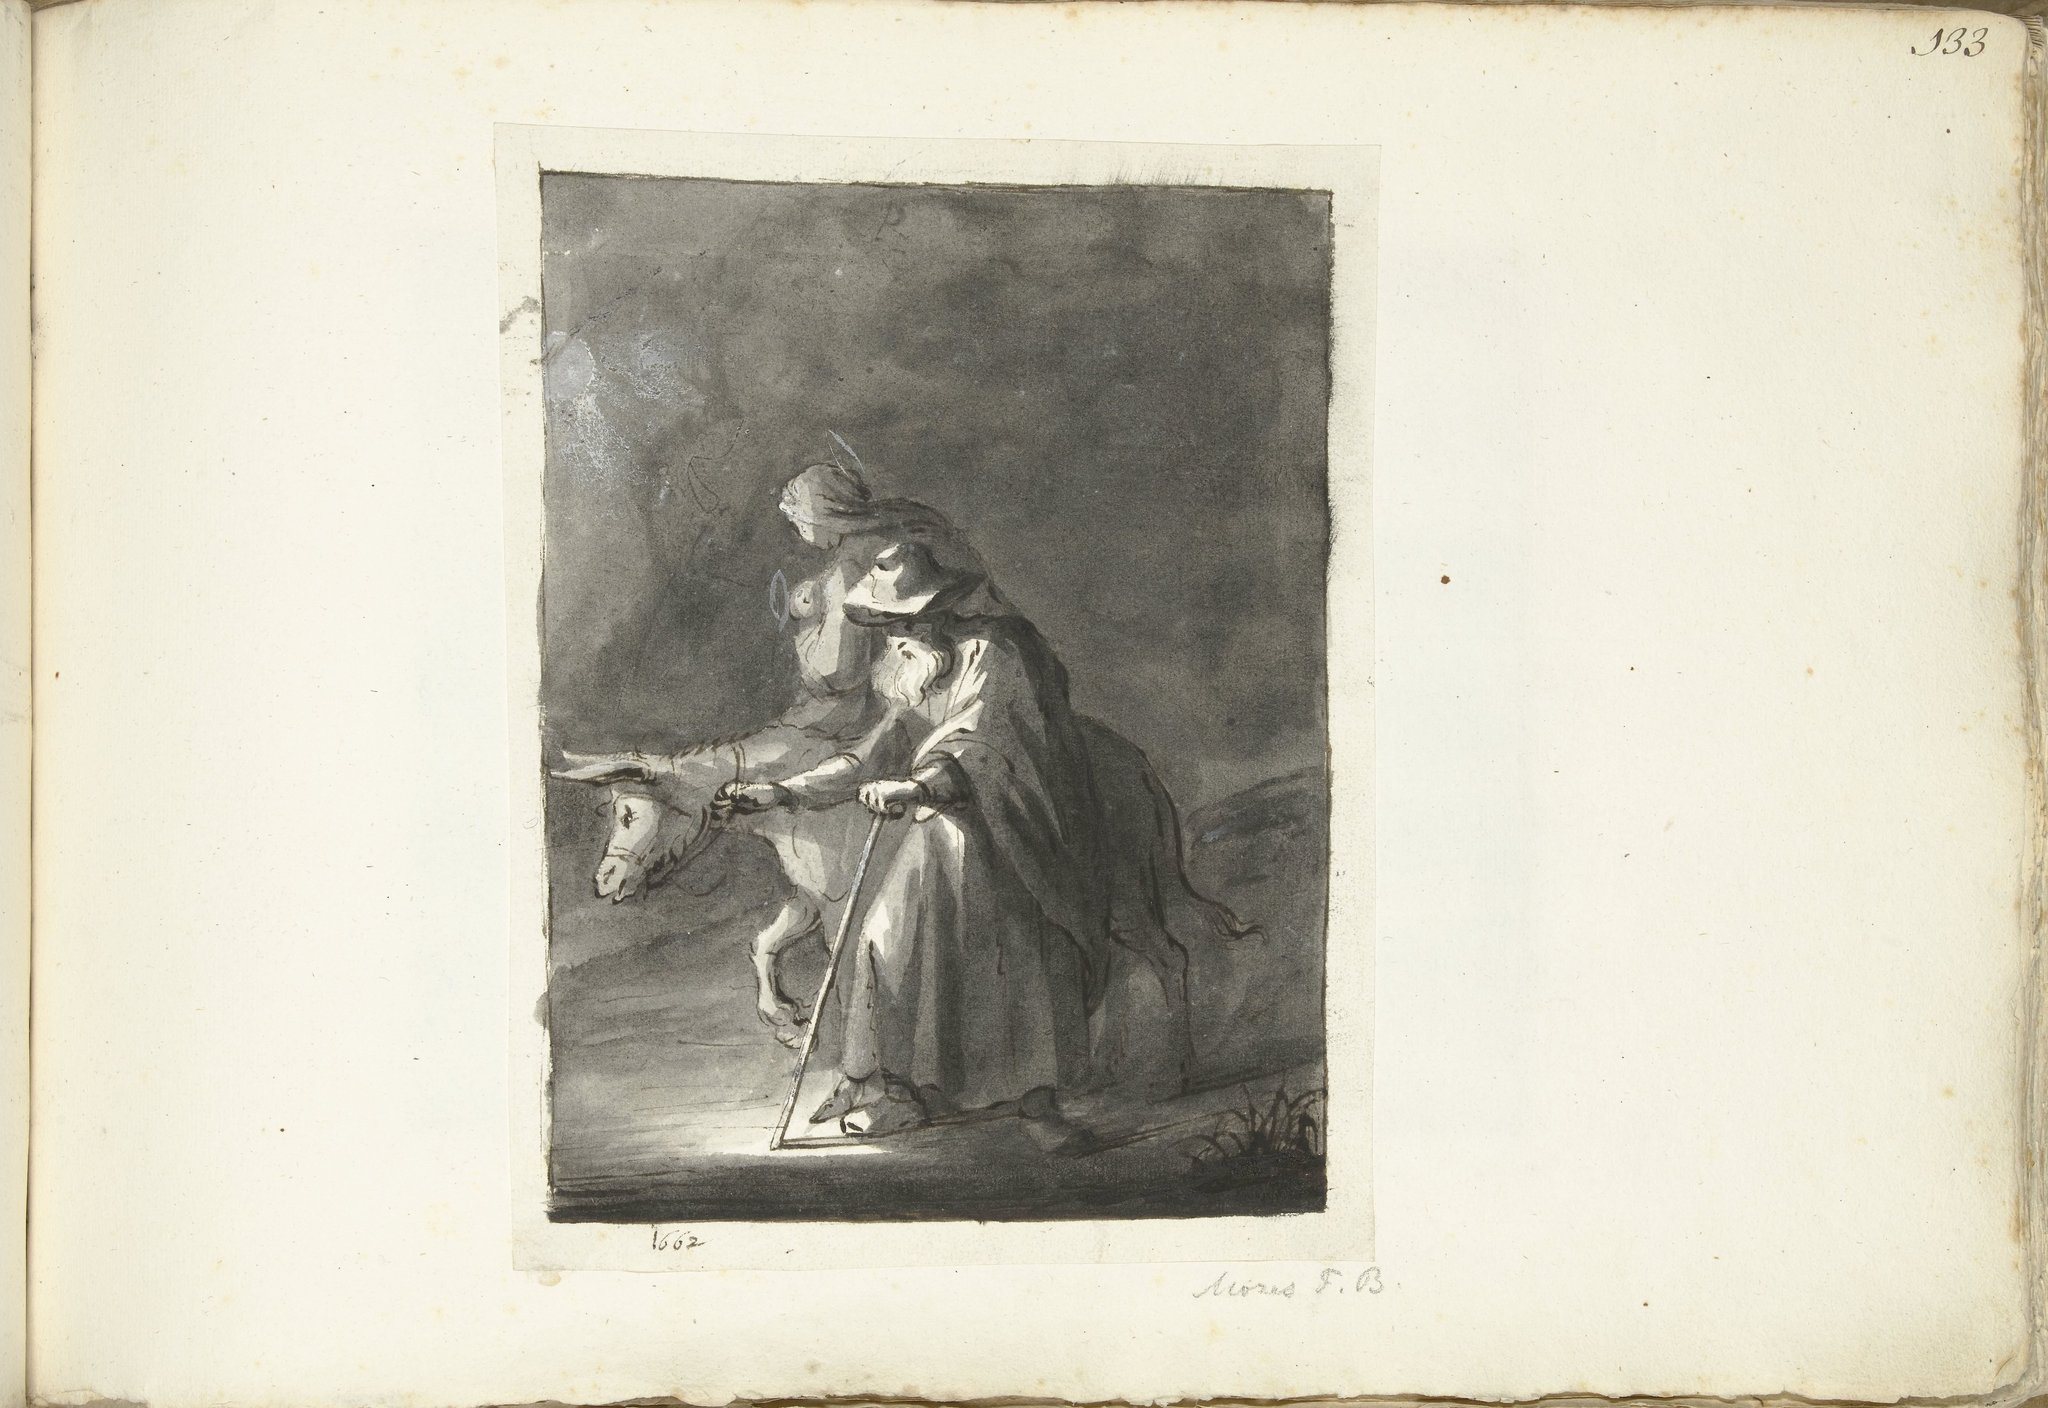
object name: drawing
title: Vlucht naar Egypte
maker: moses ter borch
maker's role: draughtsman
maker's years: 1645-1667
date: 1662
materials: paint, ink, paper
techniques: brush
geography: zwolle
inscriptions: annotation: ‘Mozes T.B.’, annotation: ‘13?’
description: Tekening opgeplakt in het Familie-plakboek.